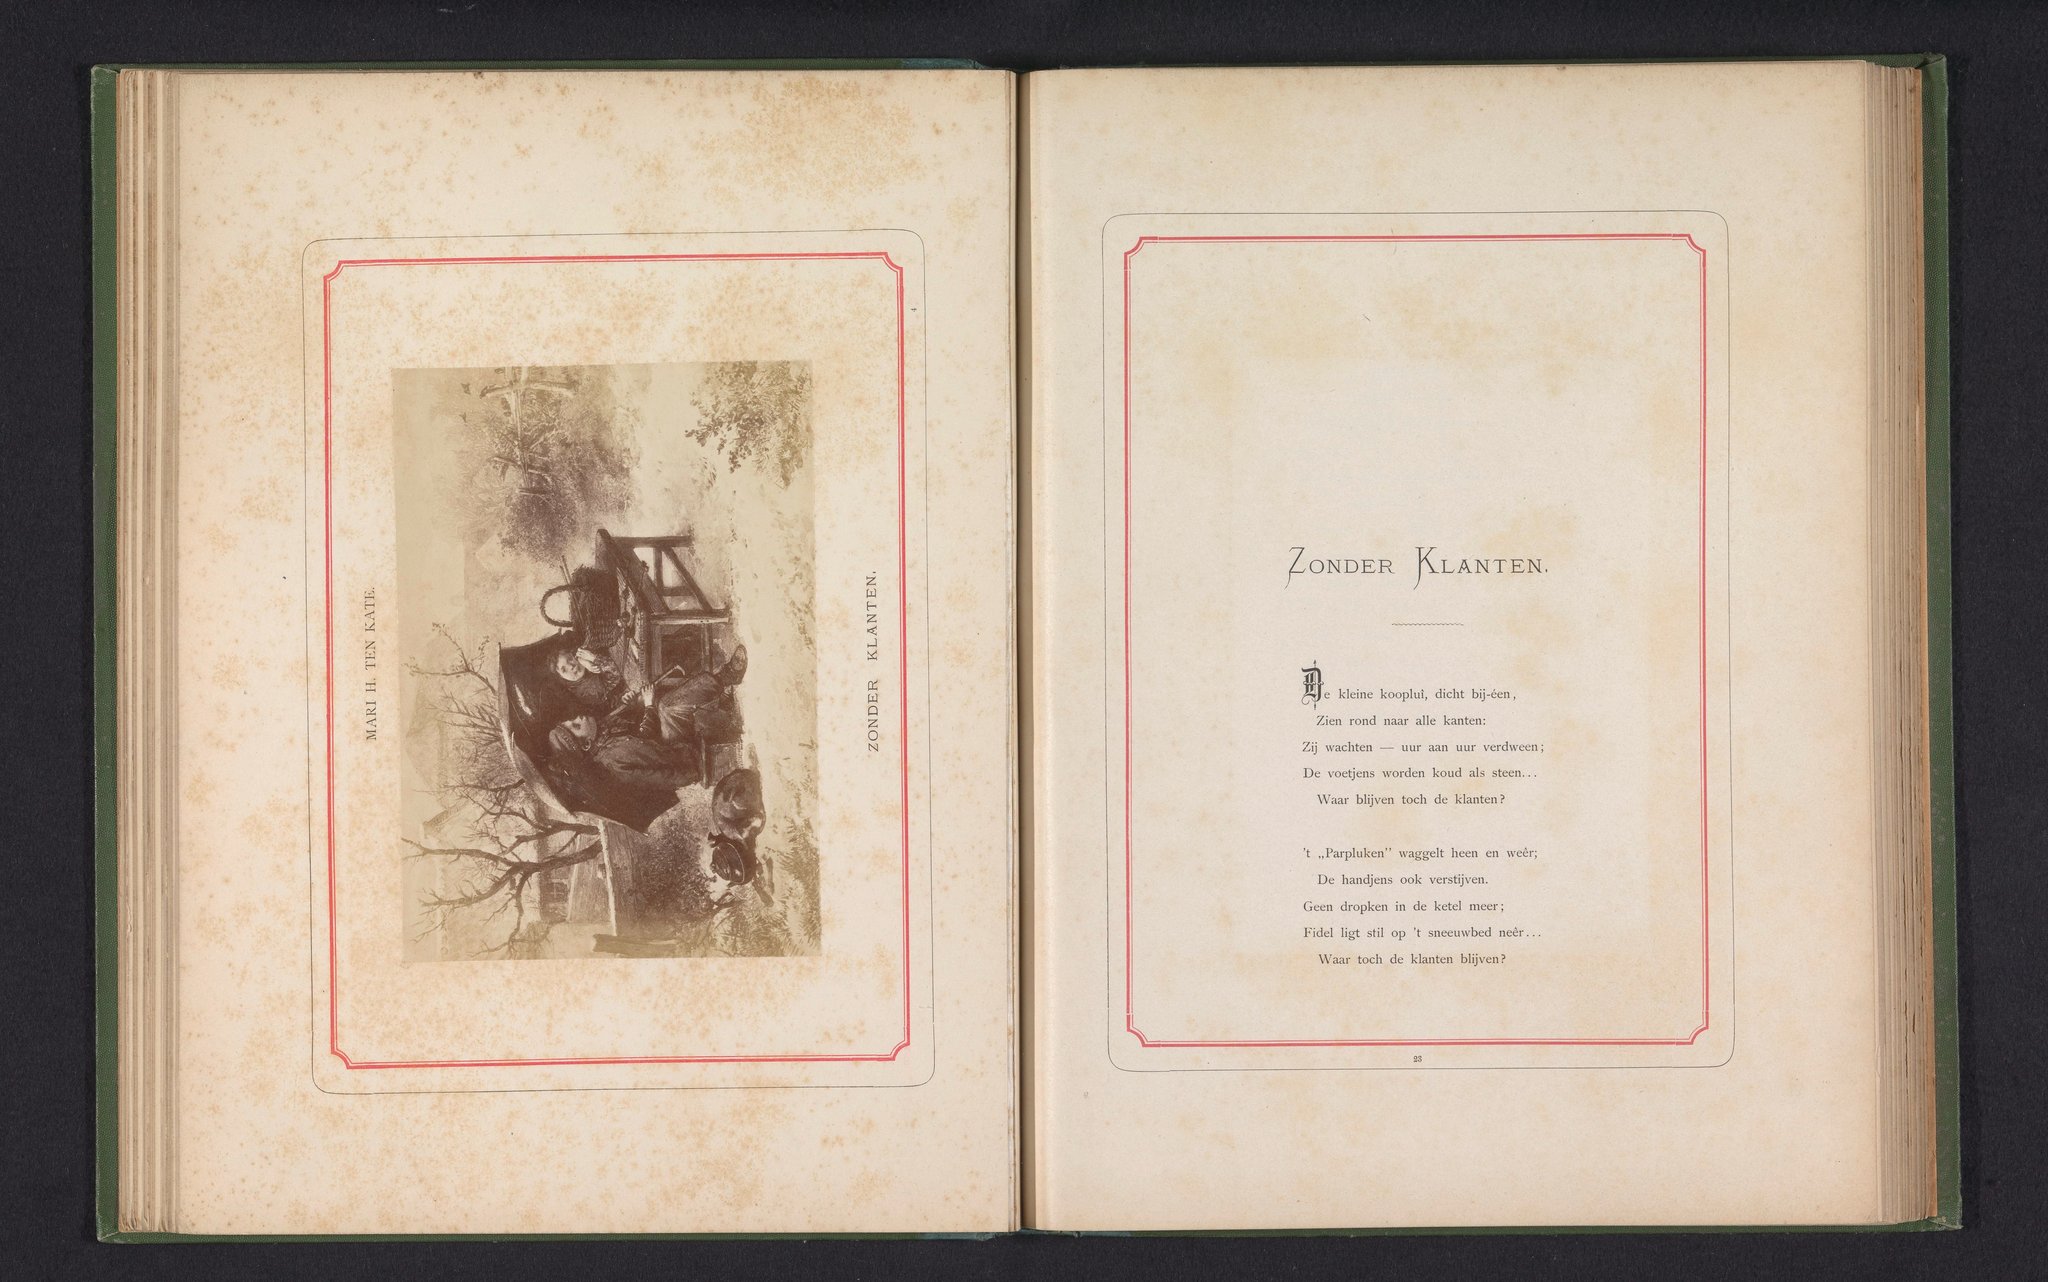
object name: photograph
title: Zonder klanten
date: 1868-1878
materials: photographic support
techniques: albumen print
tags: child, stall, booth (~ market), umbrella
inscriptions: number: ‘4’